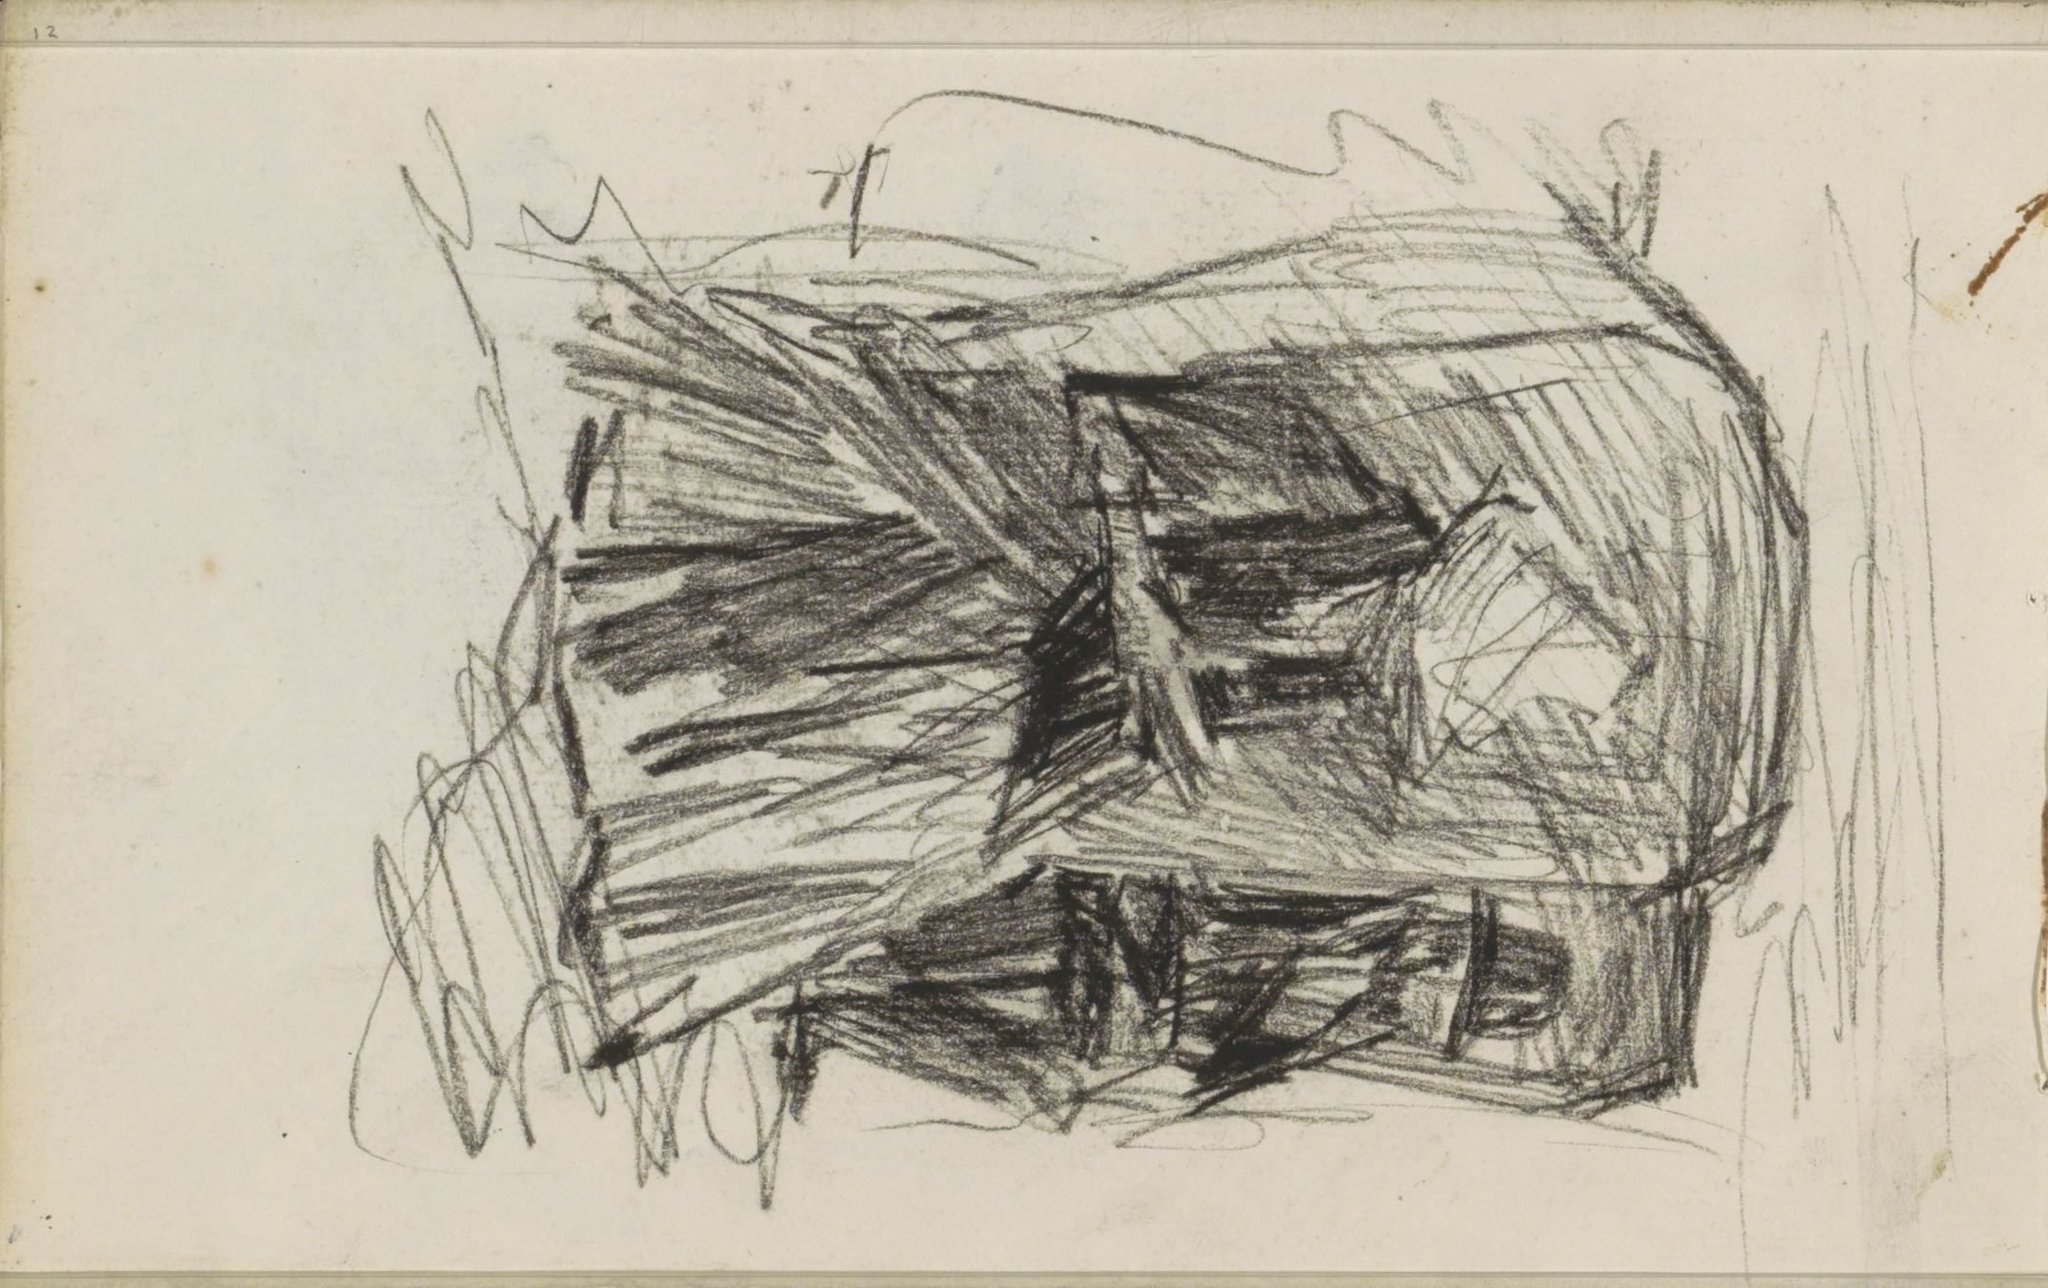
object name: sketchbook leaf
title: Man en vrouw in rieten strandstoelen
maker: marius bauer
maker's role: draughtsman, print maker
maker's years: 1867-1932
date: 1877-1885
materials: chalk, paper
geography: scheveningen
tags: beach (as place of recreation), sitting figure, adult woman, adult man, chair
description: Pagina 12 uit een schetsboek met 8 bladen.